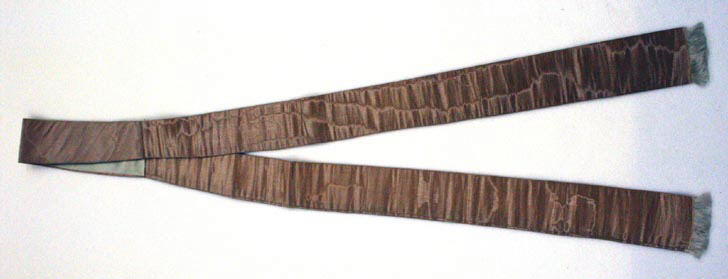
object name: wedding necktie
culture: american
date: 1856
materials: silk